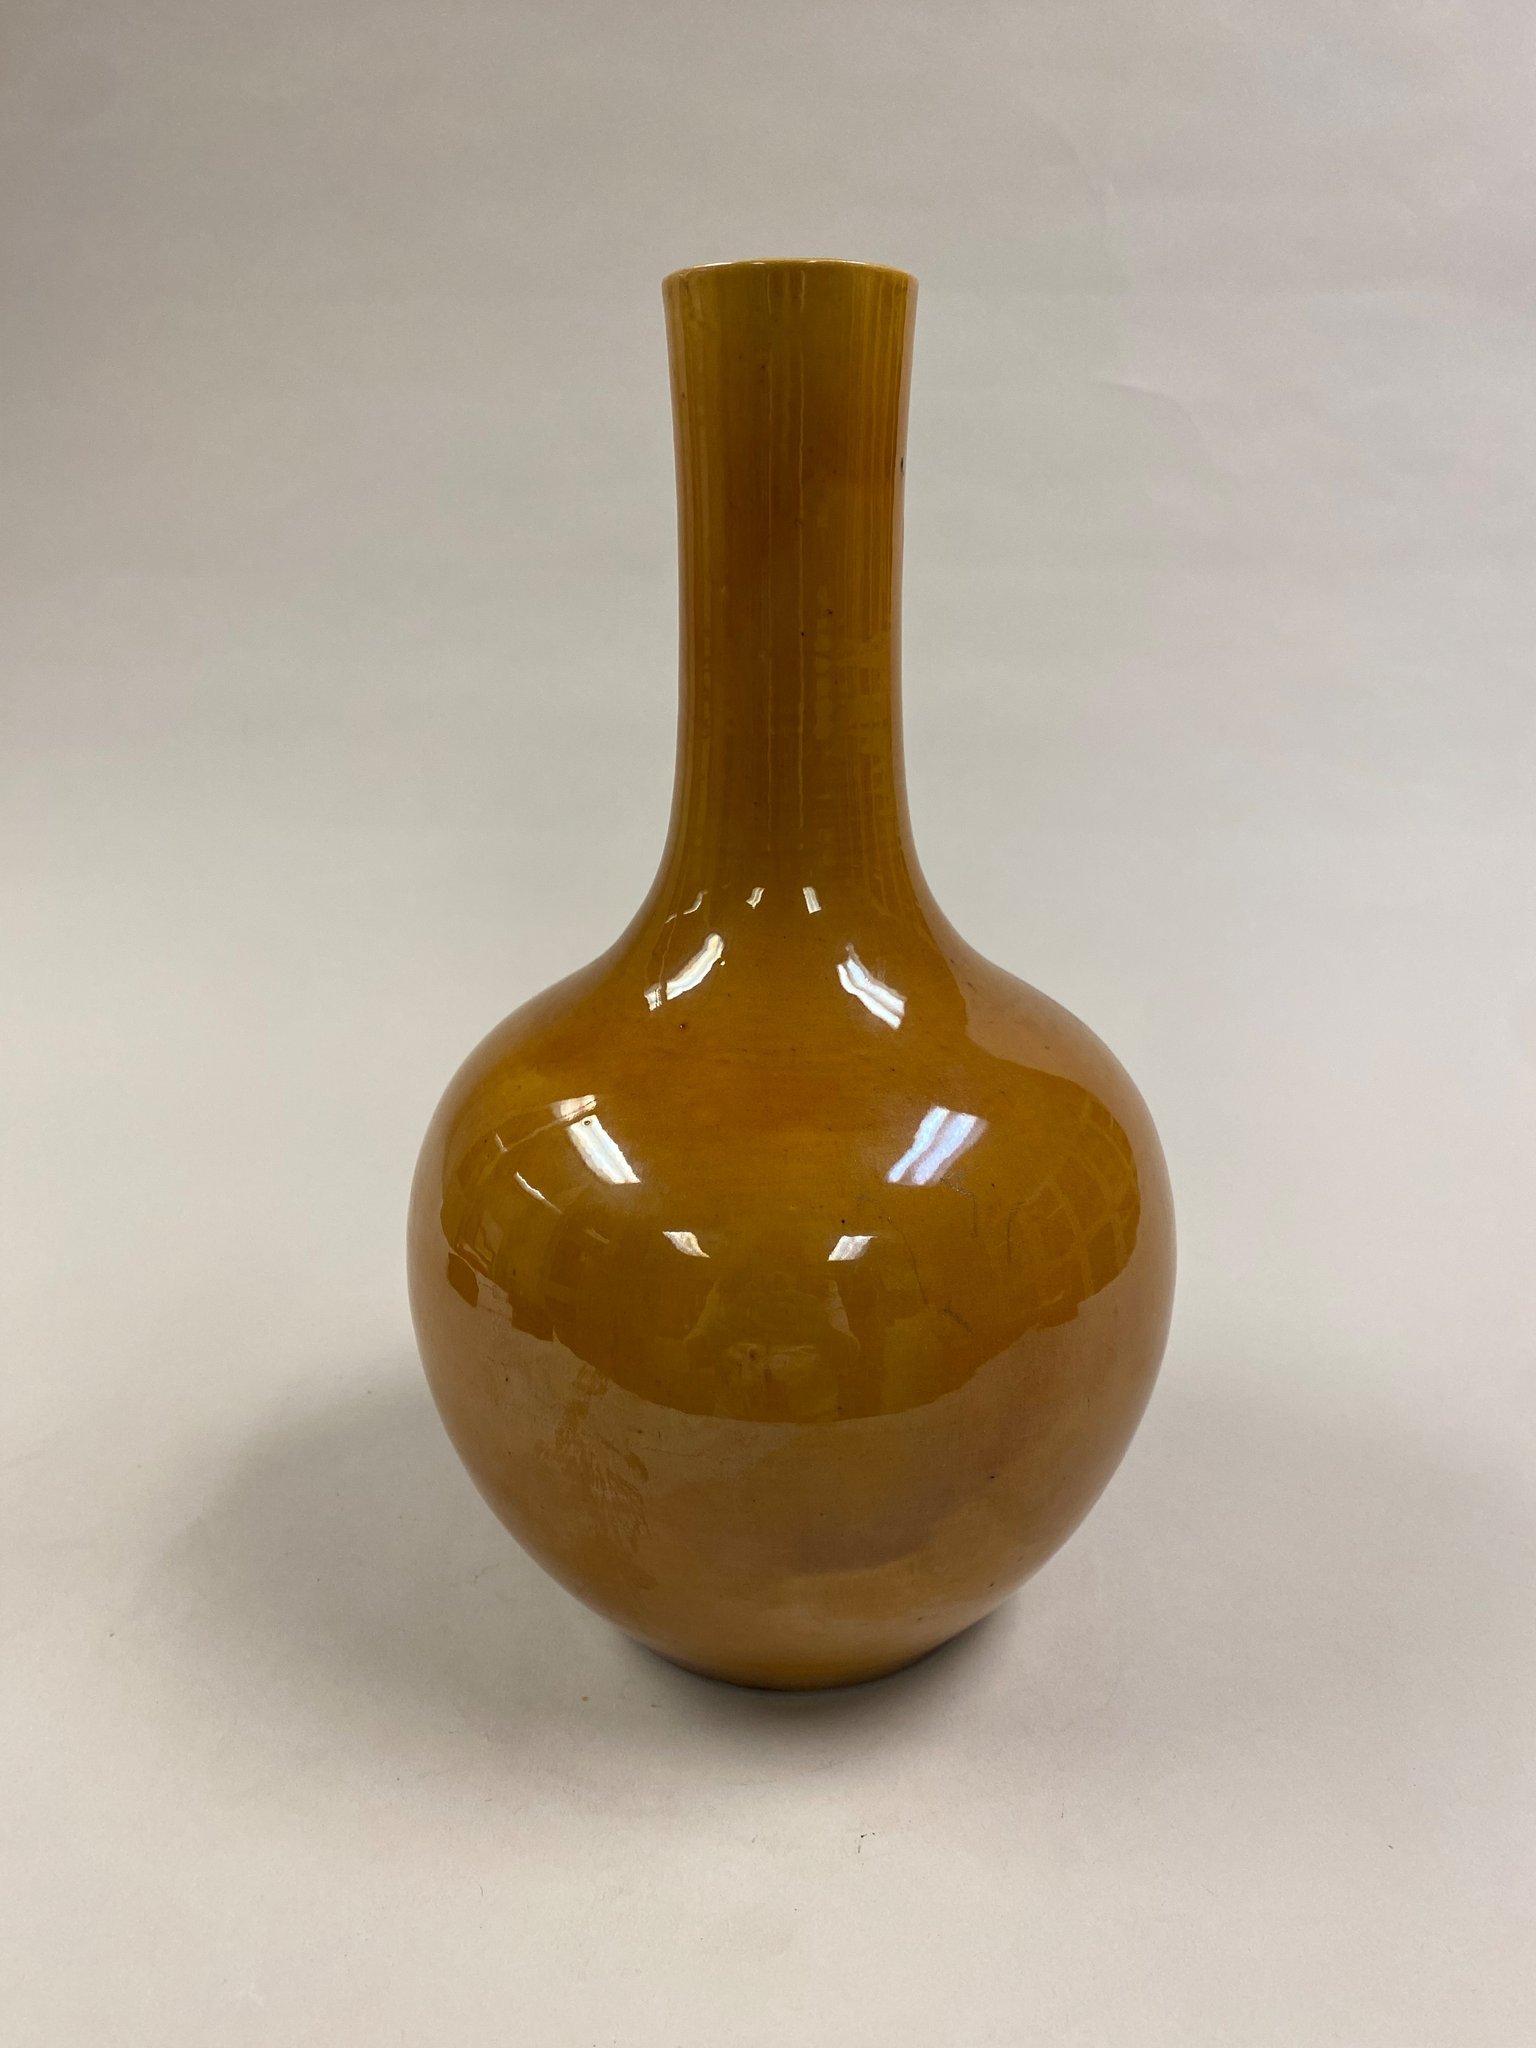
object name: bottle vase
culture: chinese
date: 1701-1800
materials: glaze, porcelain